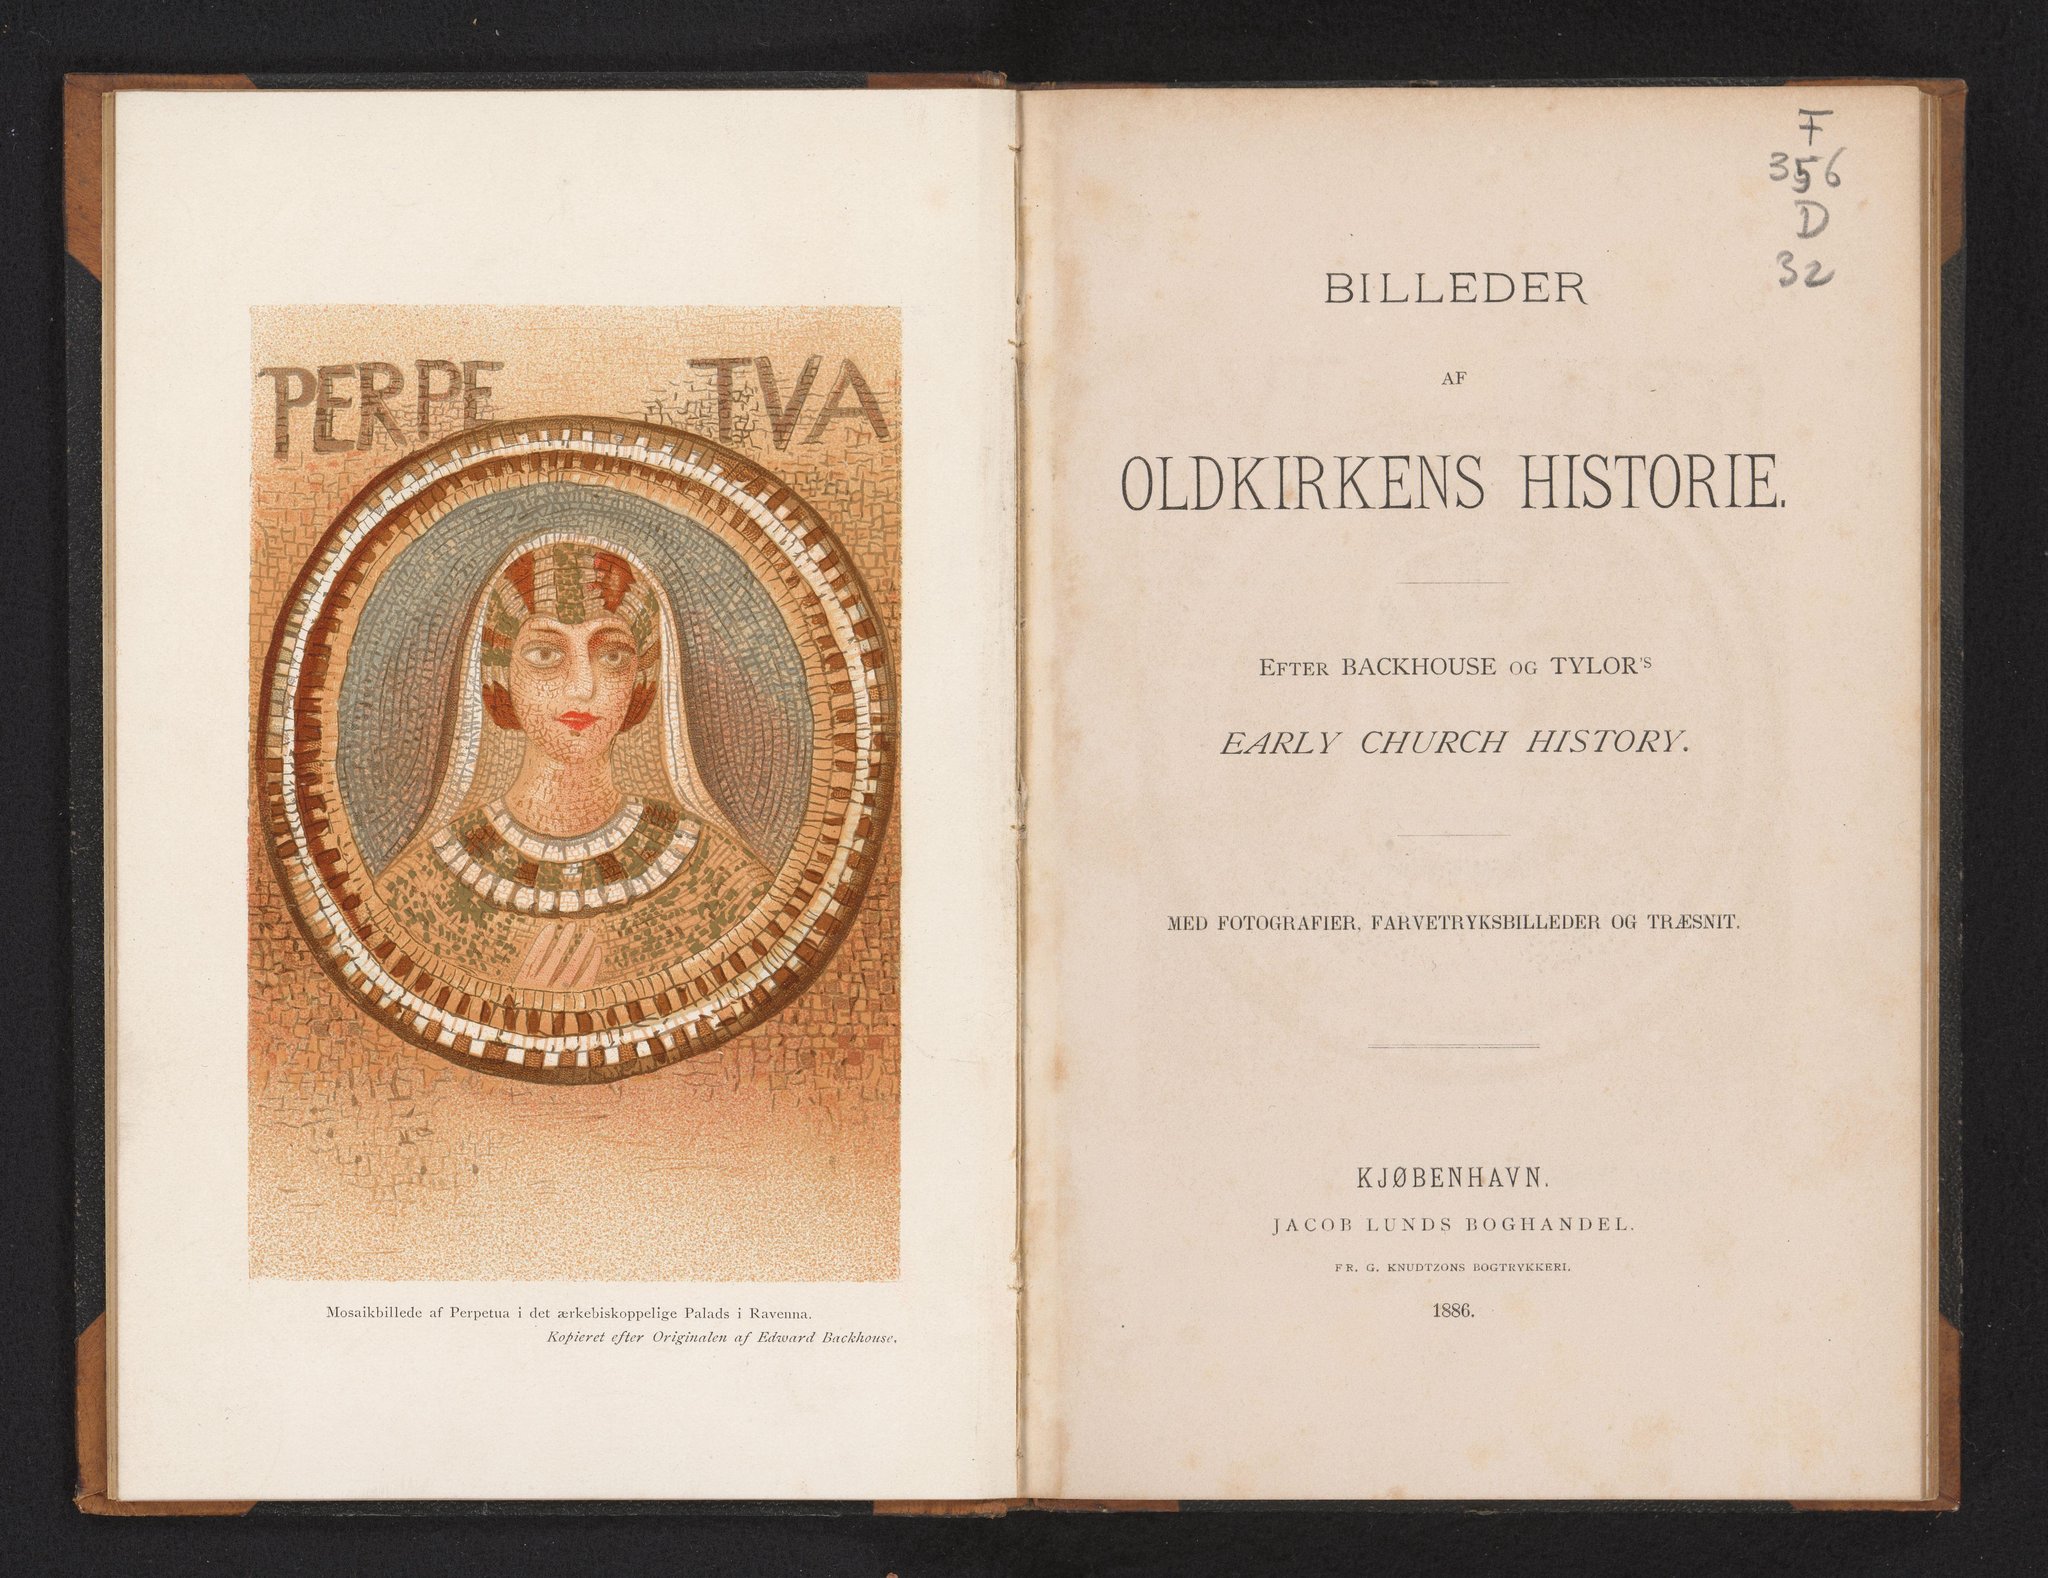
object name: book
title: Billelder af oldkirkens historie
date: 1886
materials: cardboard, leather, paper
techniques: carbon print, chromolithography, printing